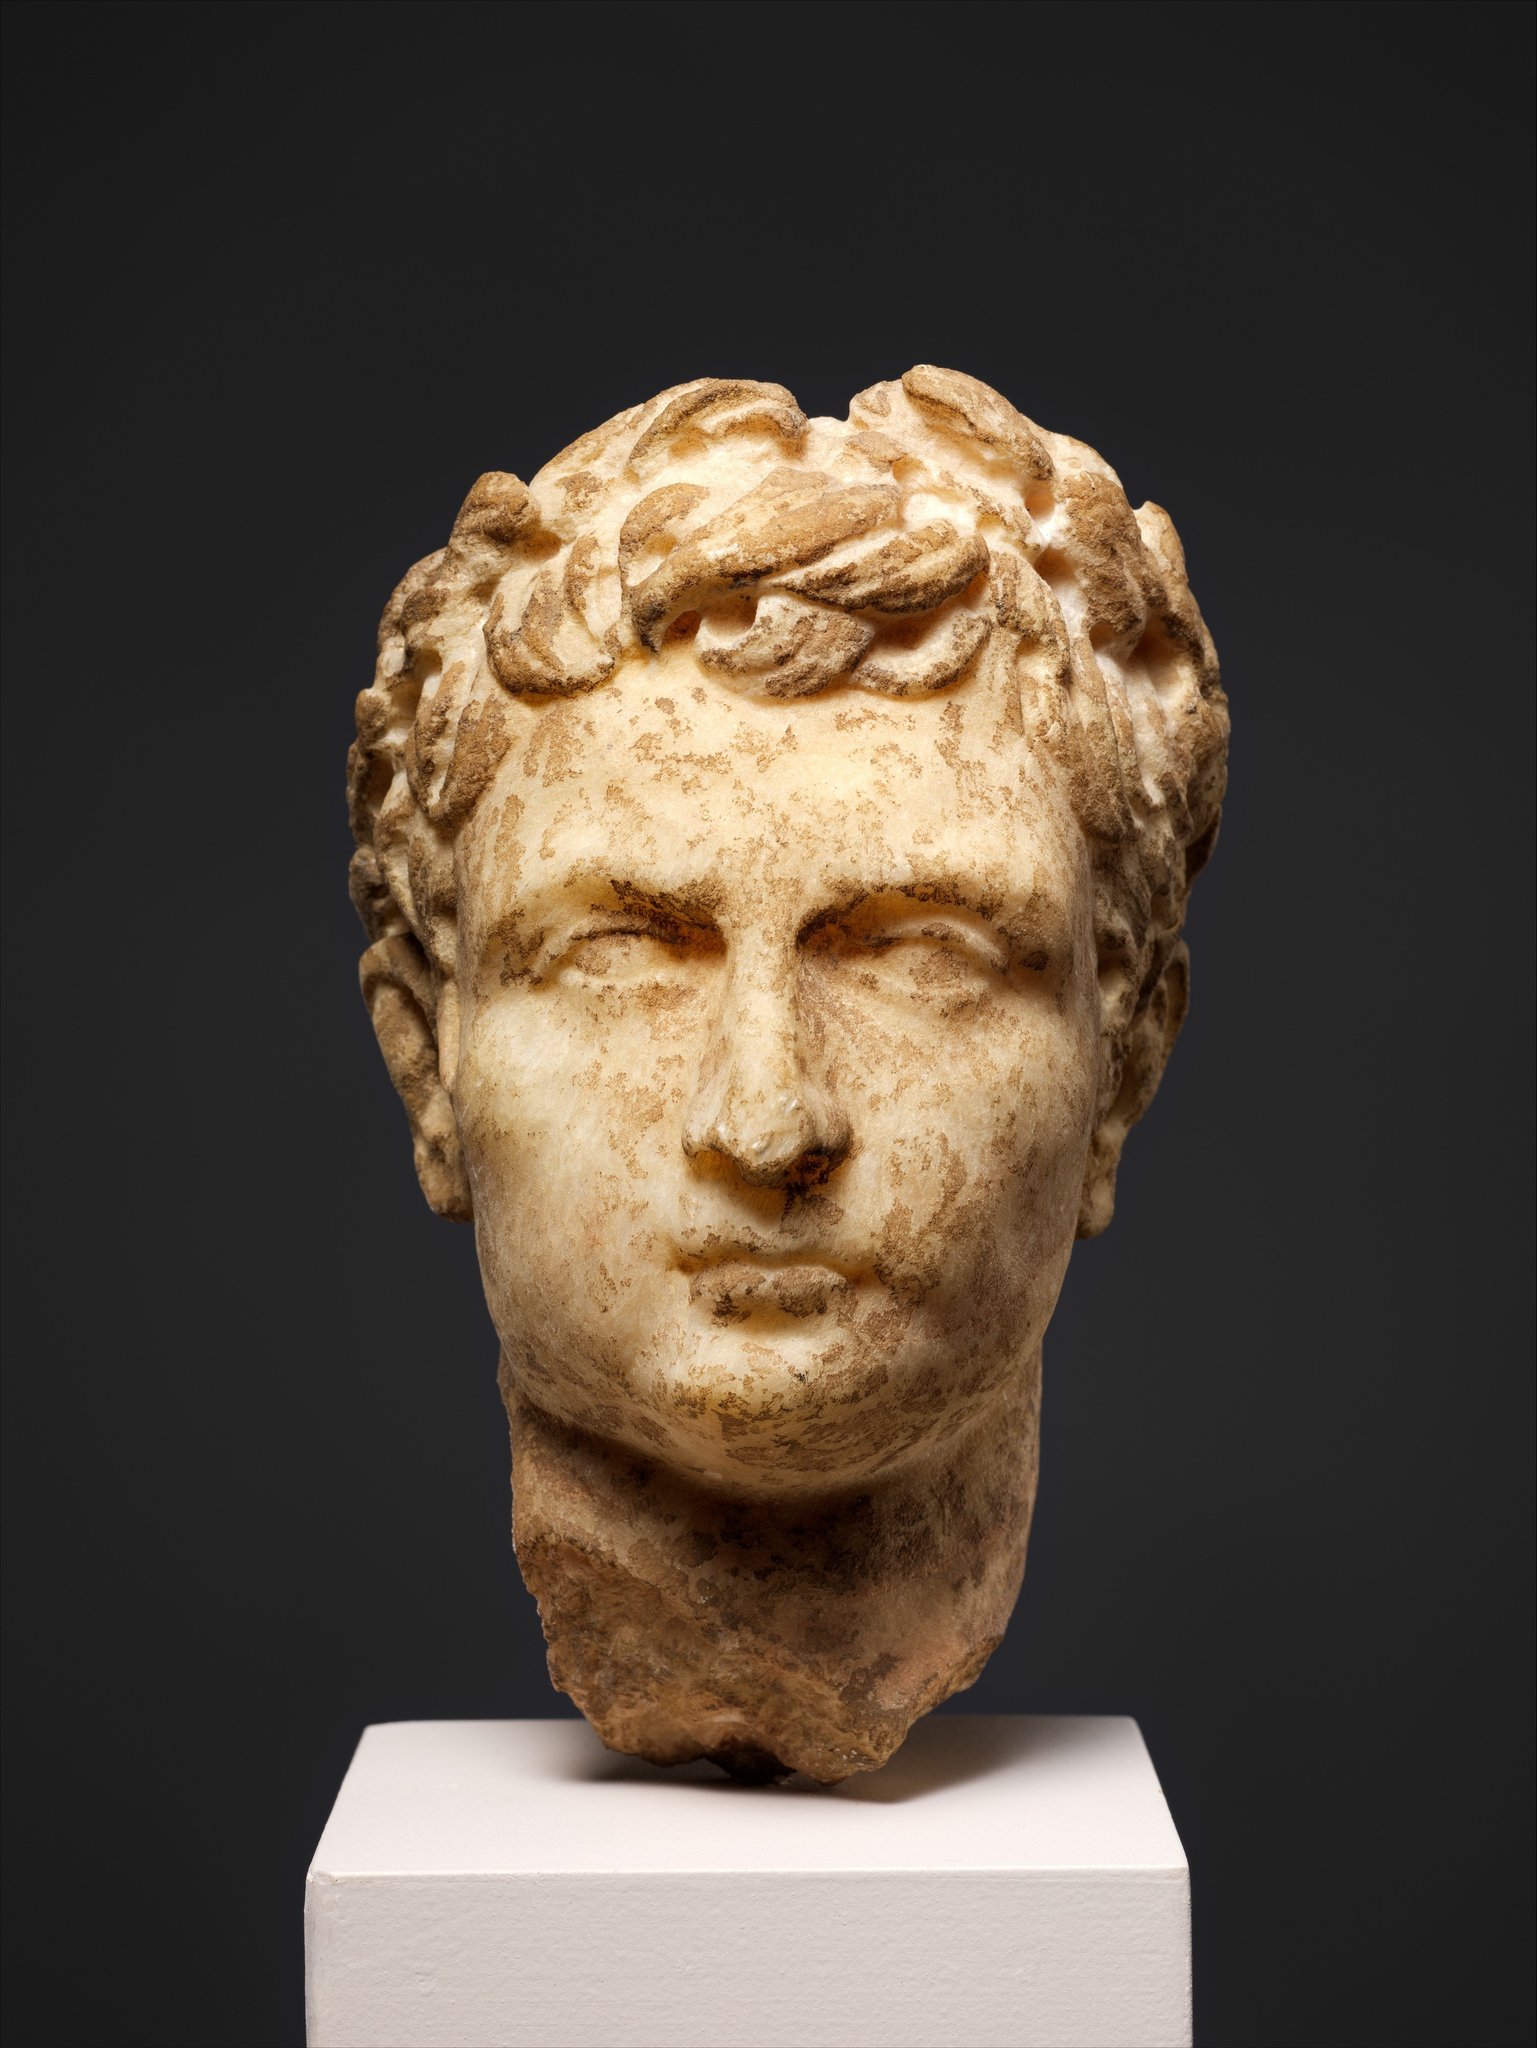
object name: head of a man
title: Marble head of a man wearing a laurel wreath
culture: roman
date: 1-100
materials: marble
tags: emperor augustus,heads